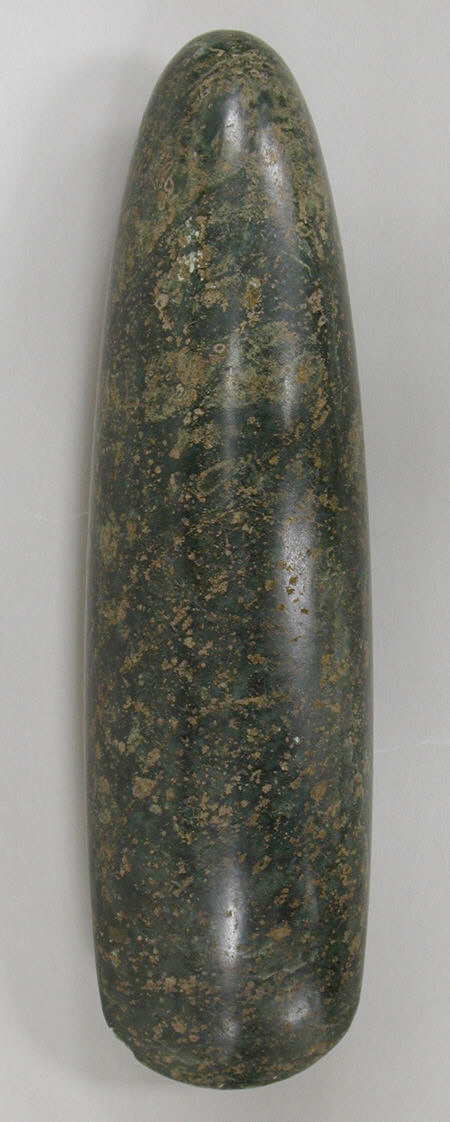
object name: celt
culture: mexican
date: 1501-1600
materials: stone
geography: mexico